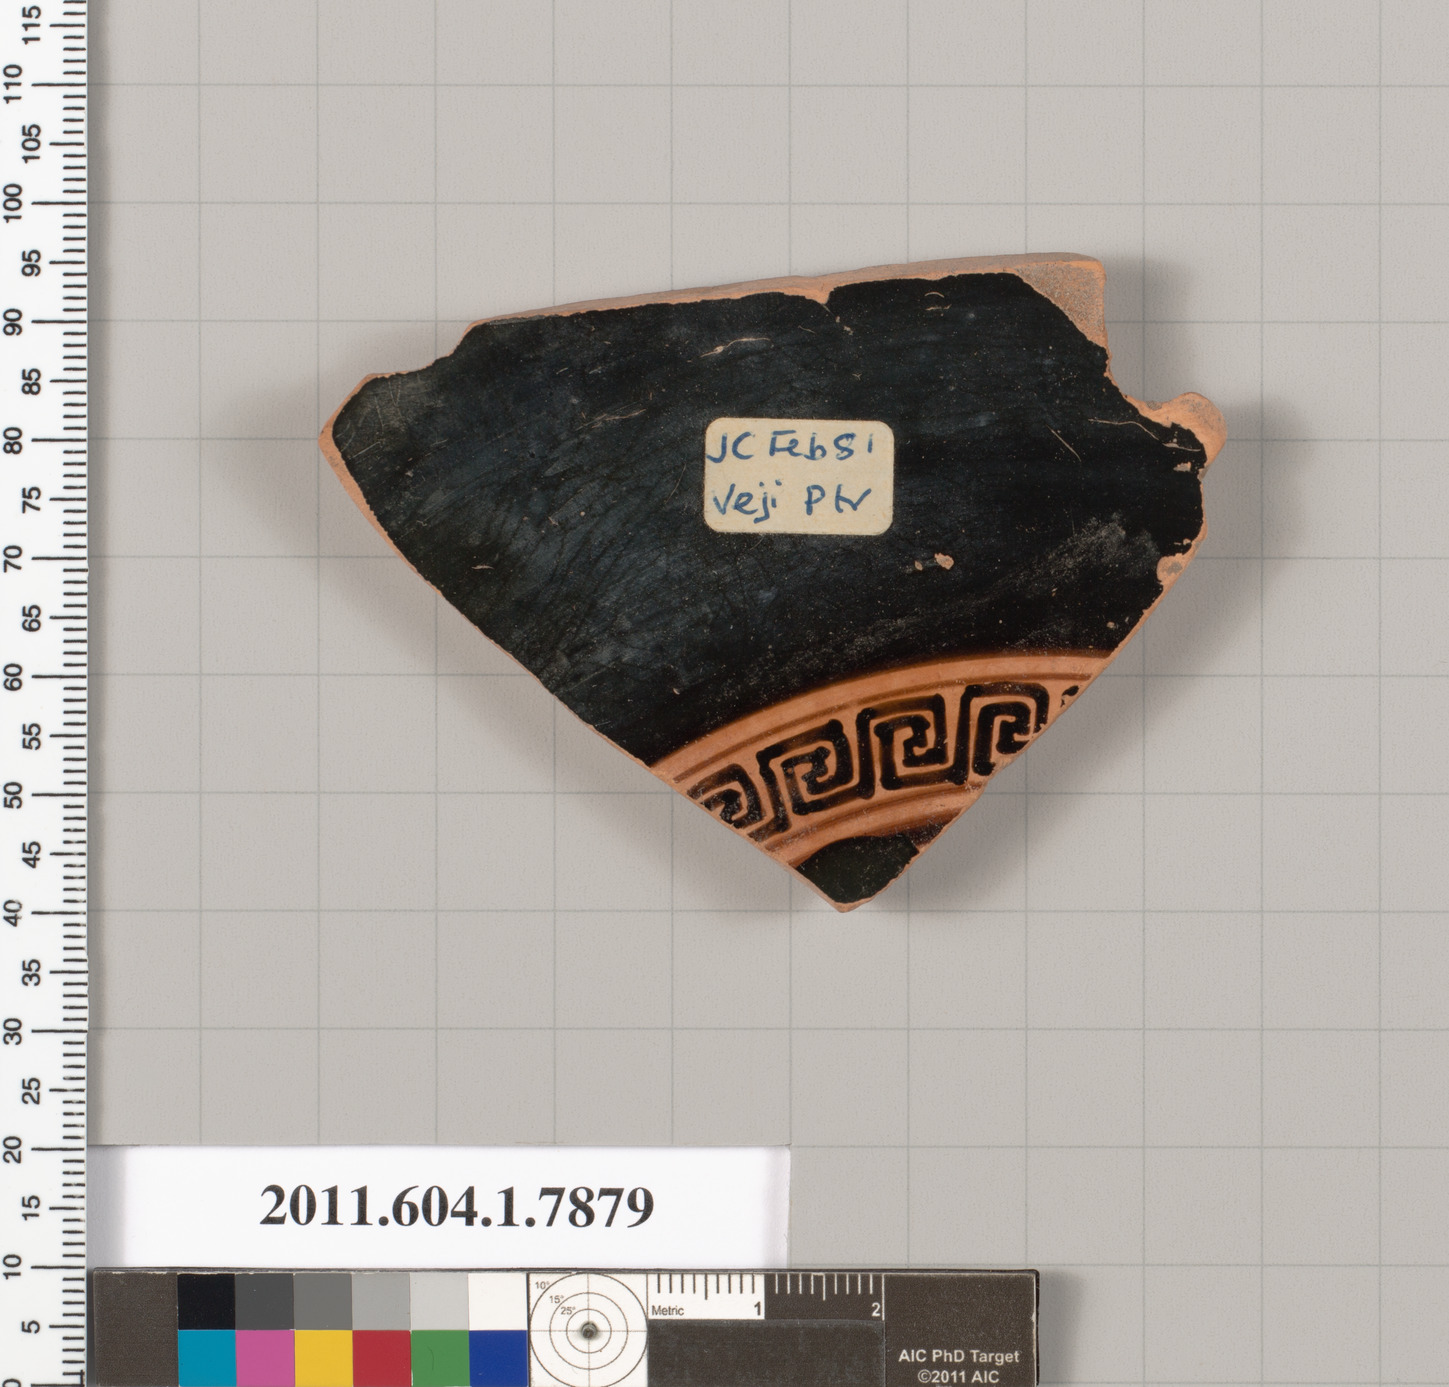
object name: kylix fragment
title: Terracotta fragment of a kylix (drinking cup)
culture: greek, attic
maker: veii painter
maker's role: artist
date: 460-450 BCE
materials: terracotta